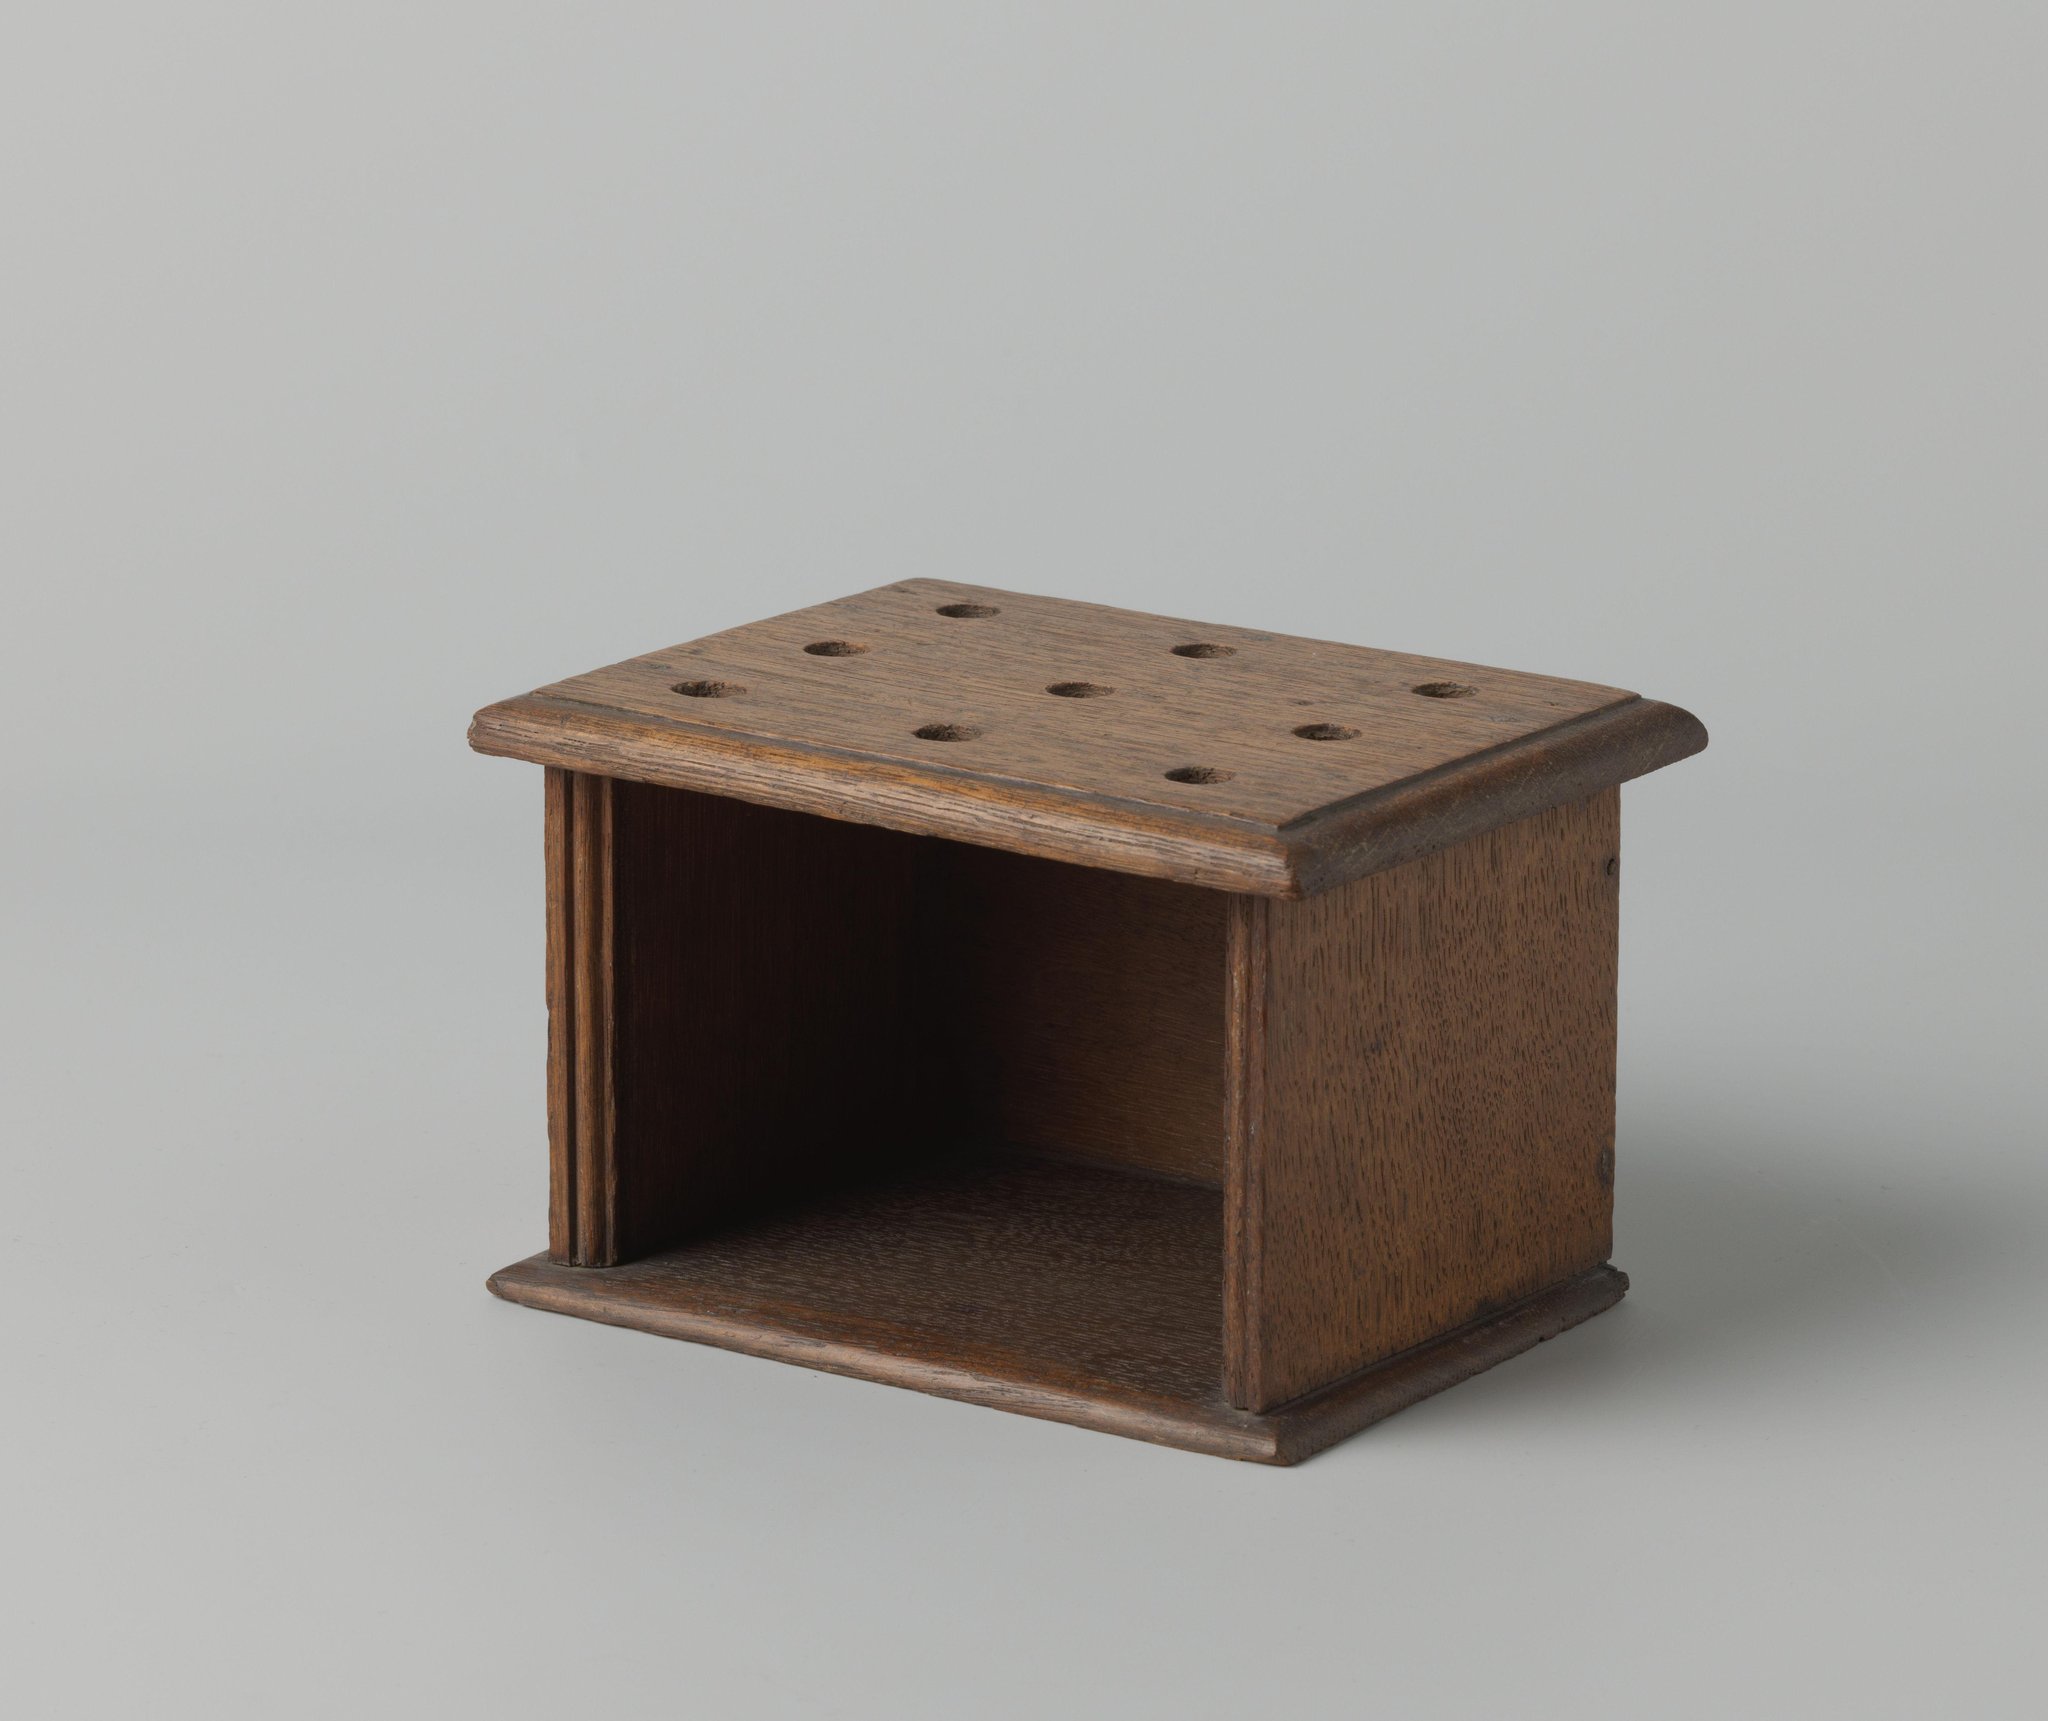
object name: miniature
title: Poppenstoof met negen gaten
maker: Anonymous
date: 1400-1950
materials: wood